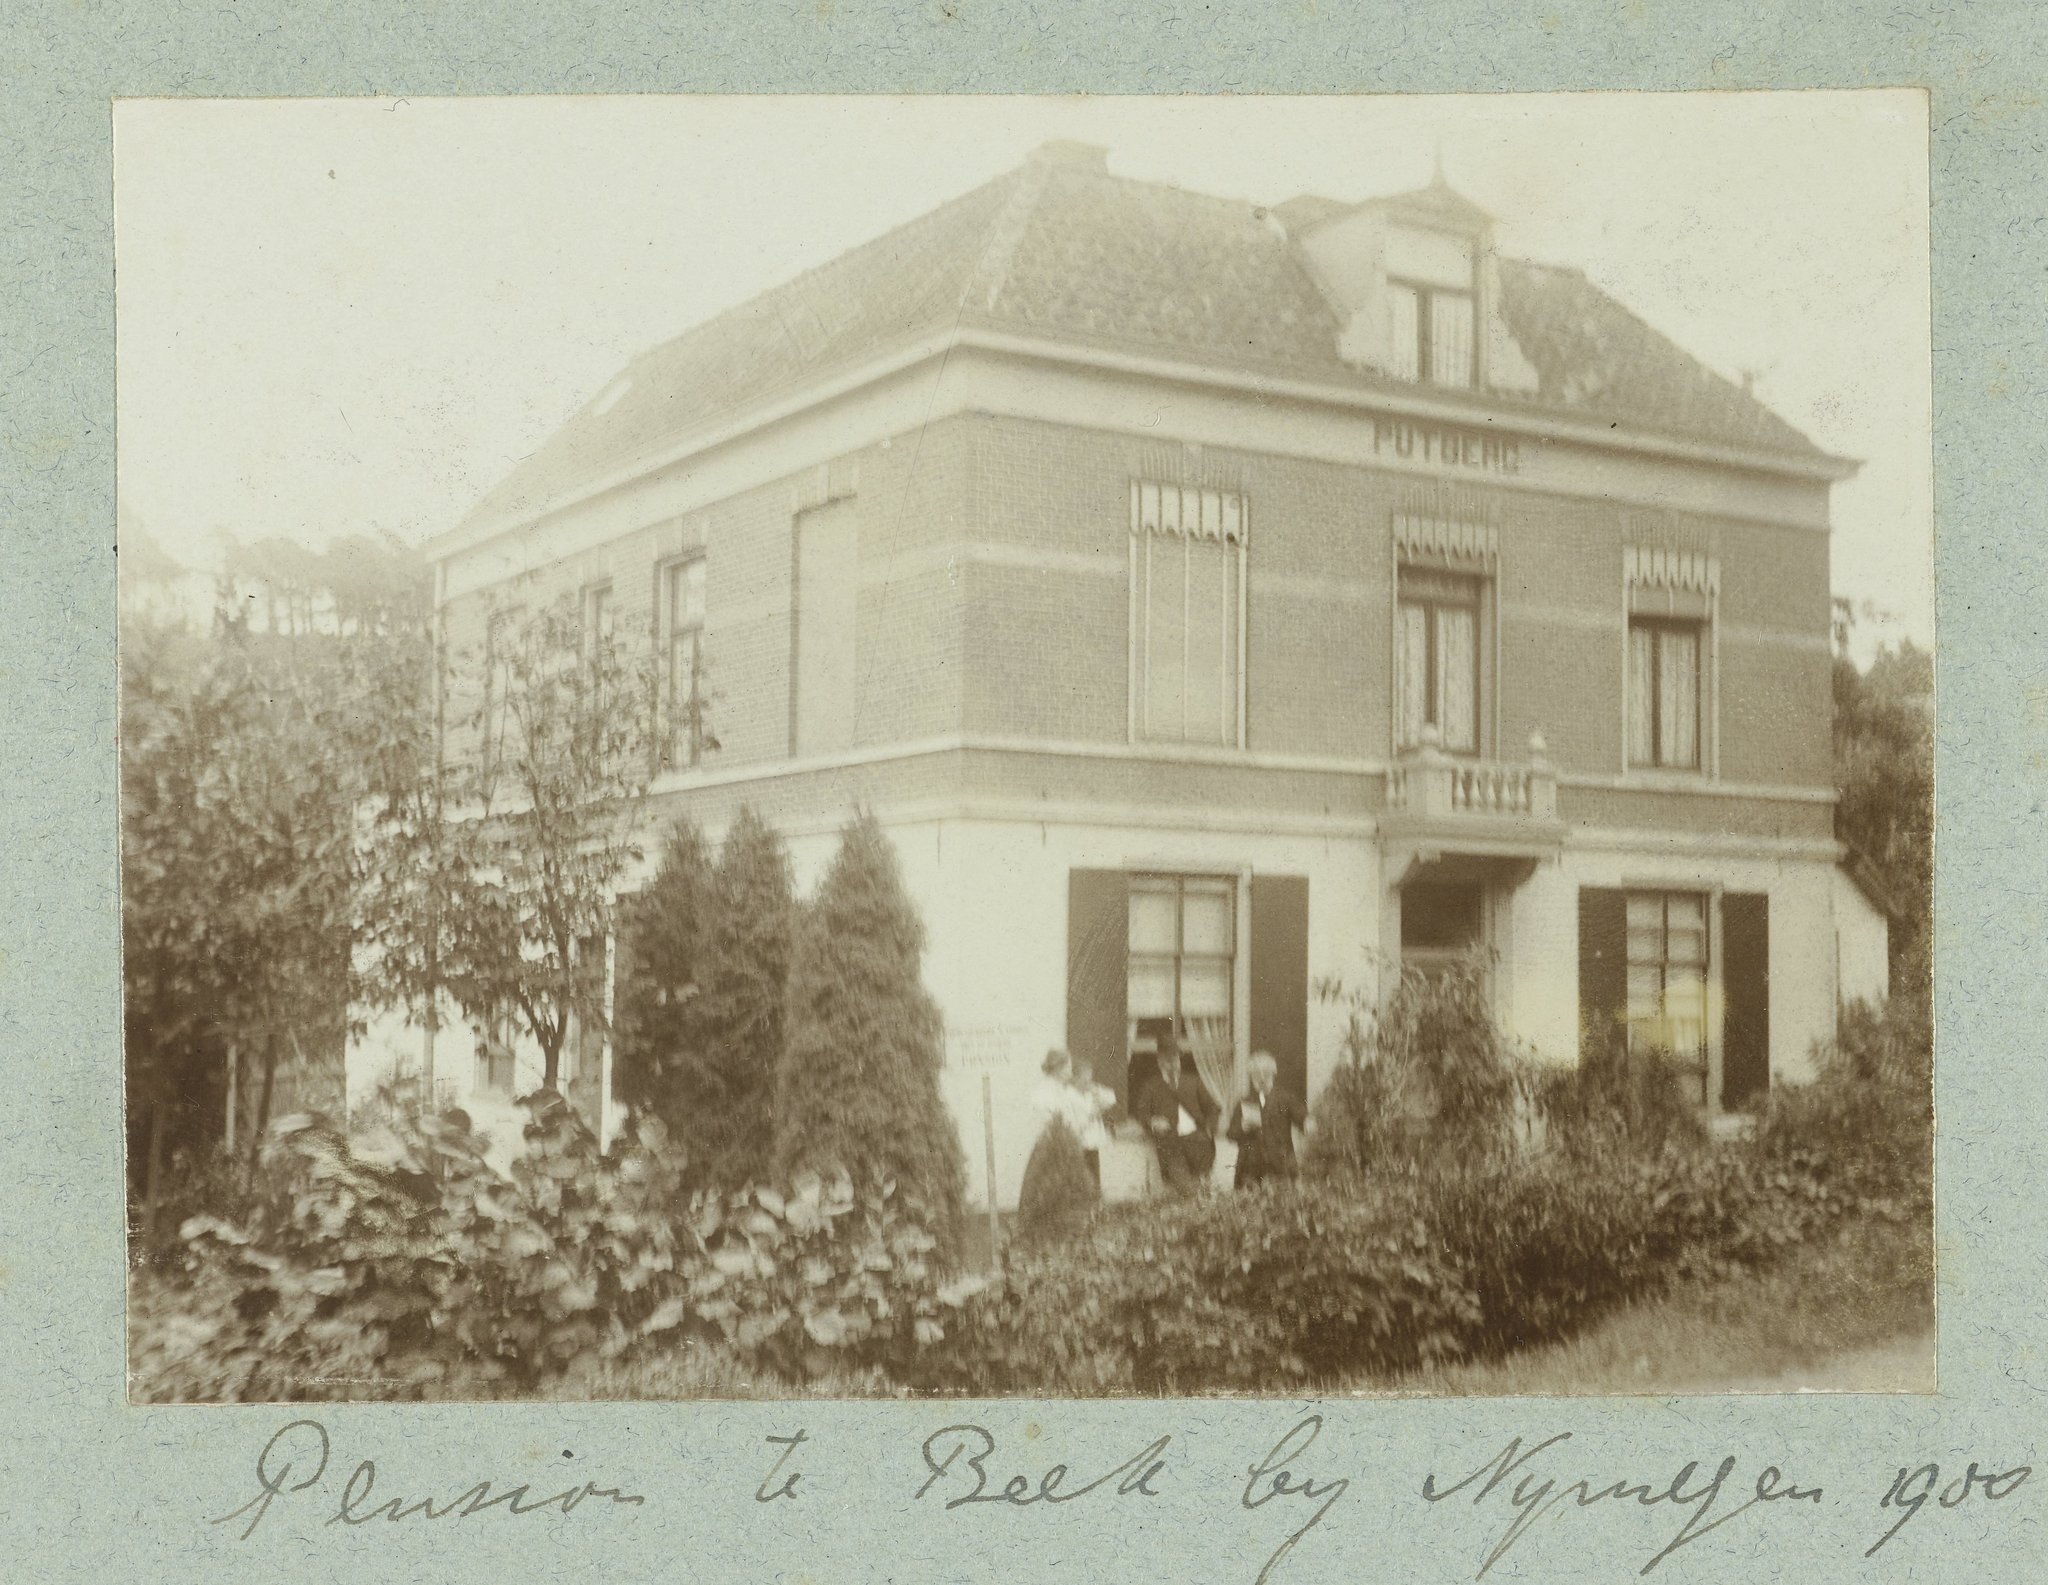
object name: photograph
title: Putberg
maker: frits freerks fontein fz.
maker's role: fotograaf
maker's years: 1882-1928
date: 1900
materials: cardboard, paper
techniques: gelatin silver print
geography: netherlands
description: Voor het pension staat een aantal personen. De gevel draagt de naam 'Putberg'. Foto uit album 'Photographieën".